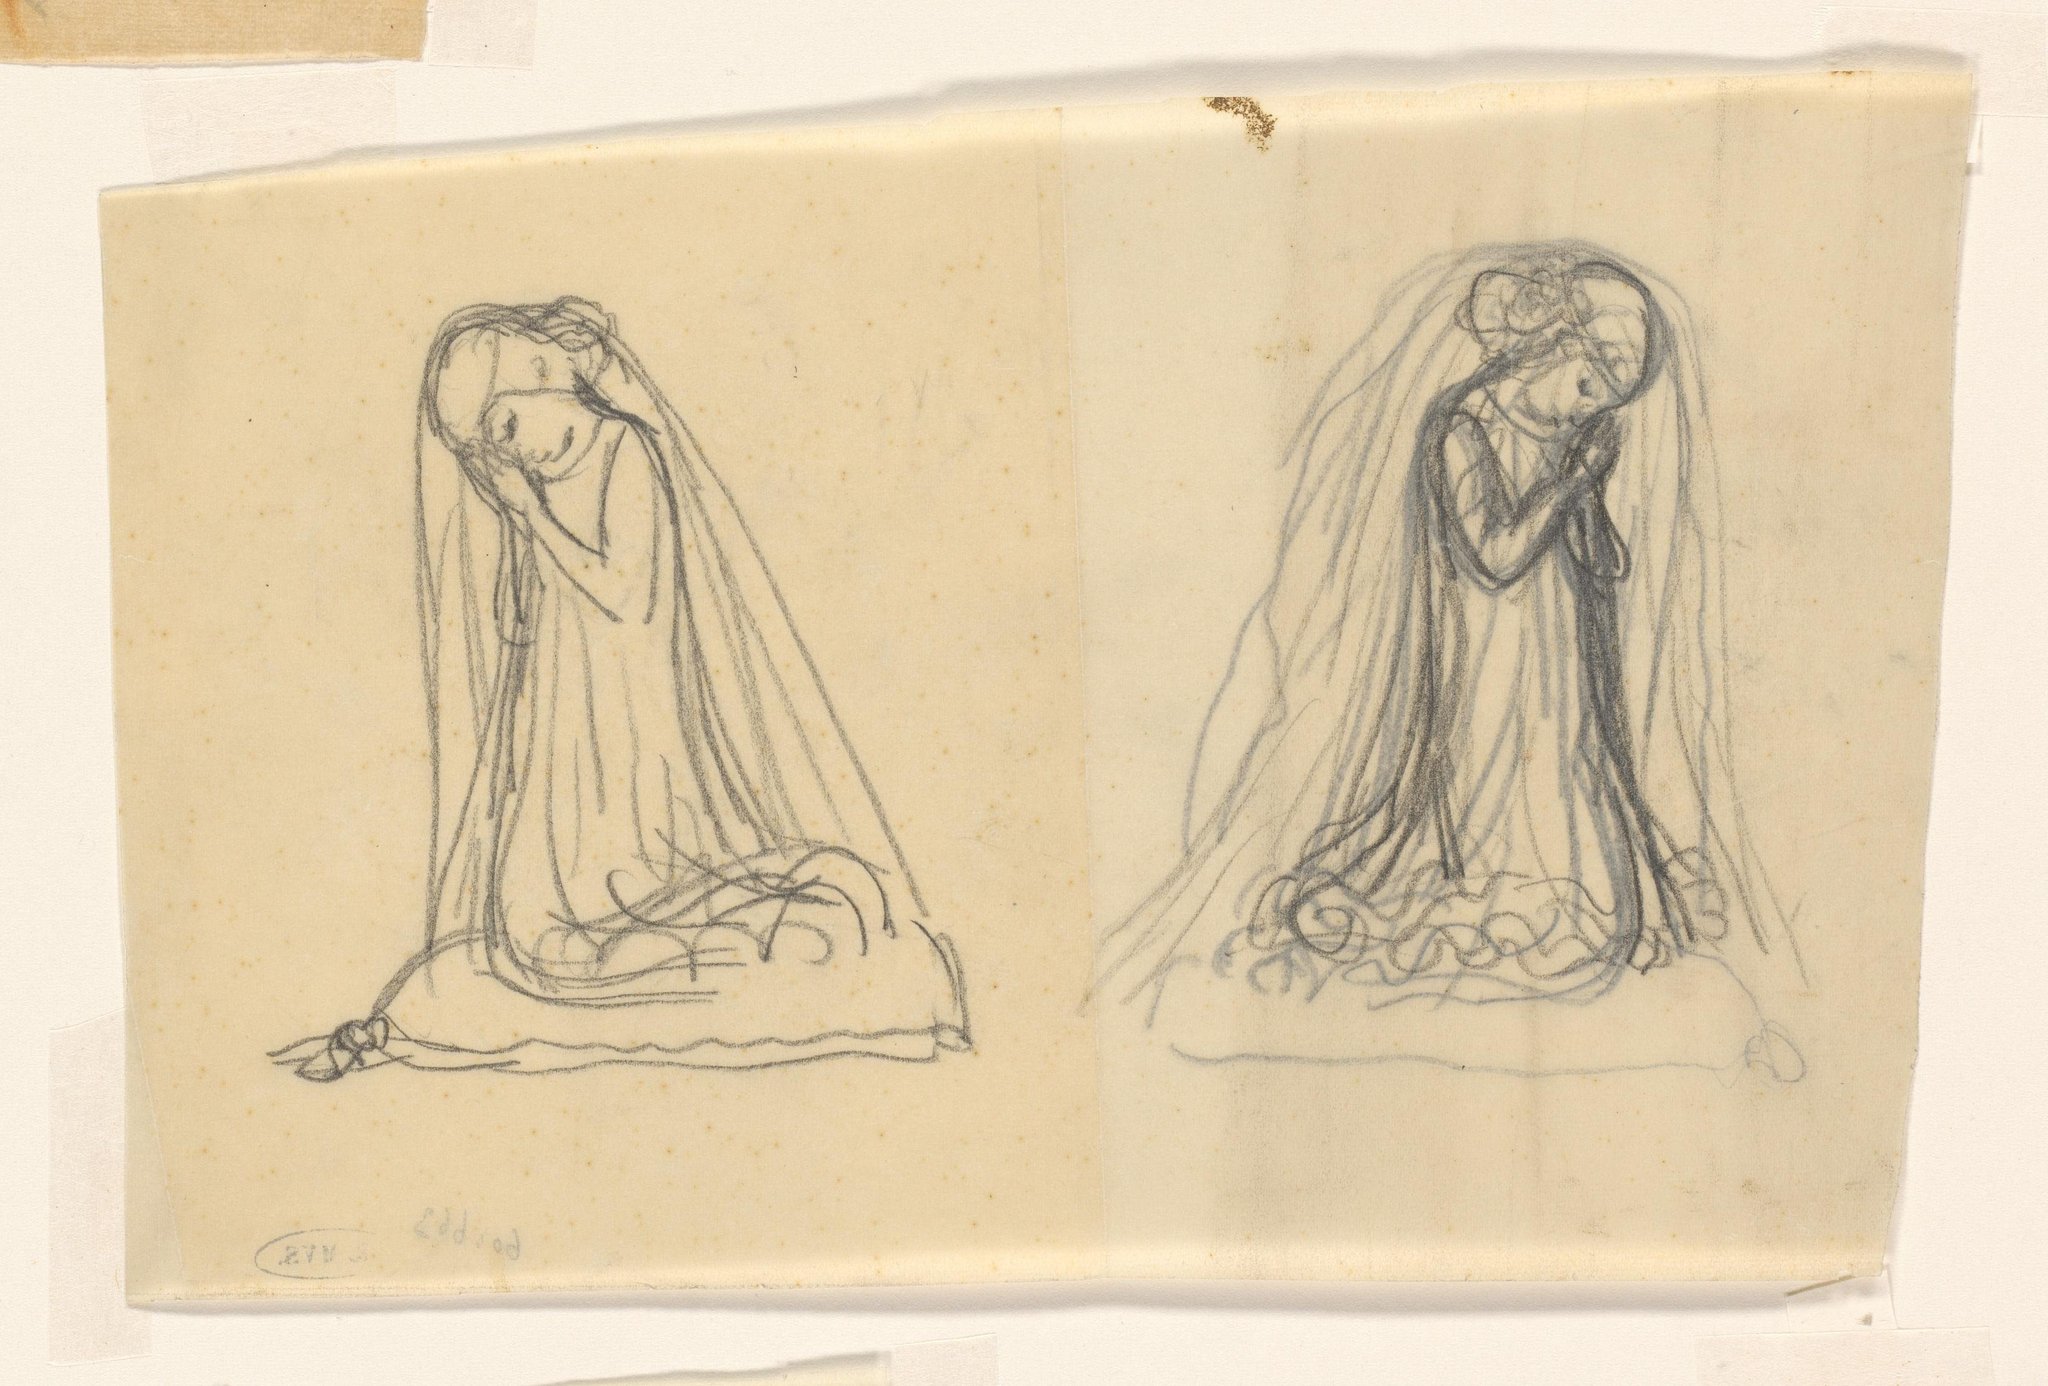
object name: drawing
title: Biddend meisje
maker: leo gestel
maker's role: draughtsman, print maker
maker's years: 1881-1941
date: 1930-1935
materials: pencil, paper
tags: girl (child between toddler and youth), kneeling figure, holy communion ~ protestant service